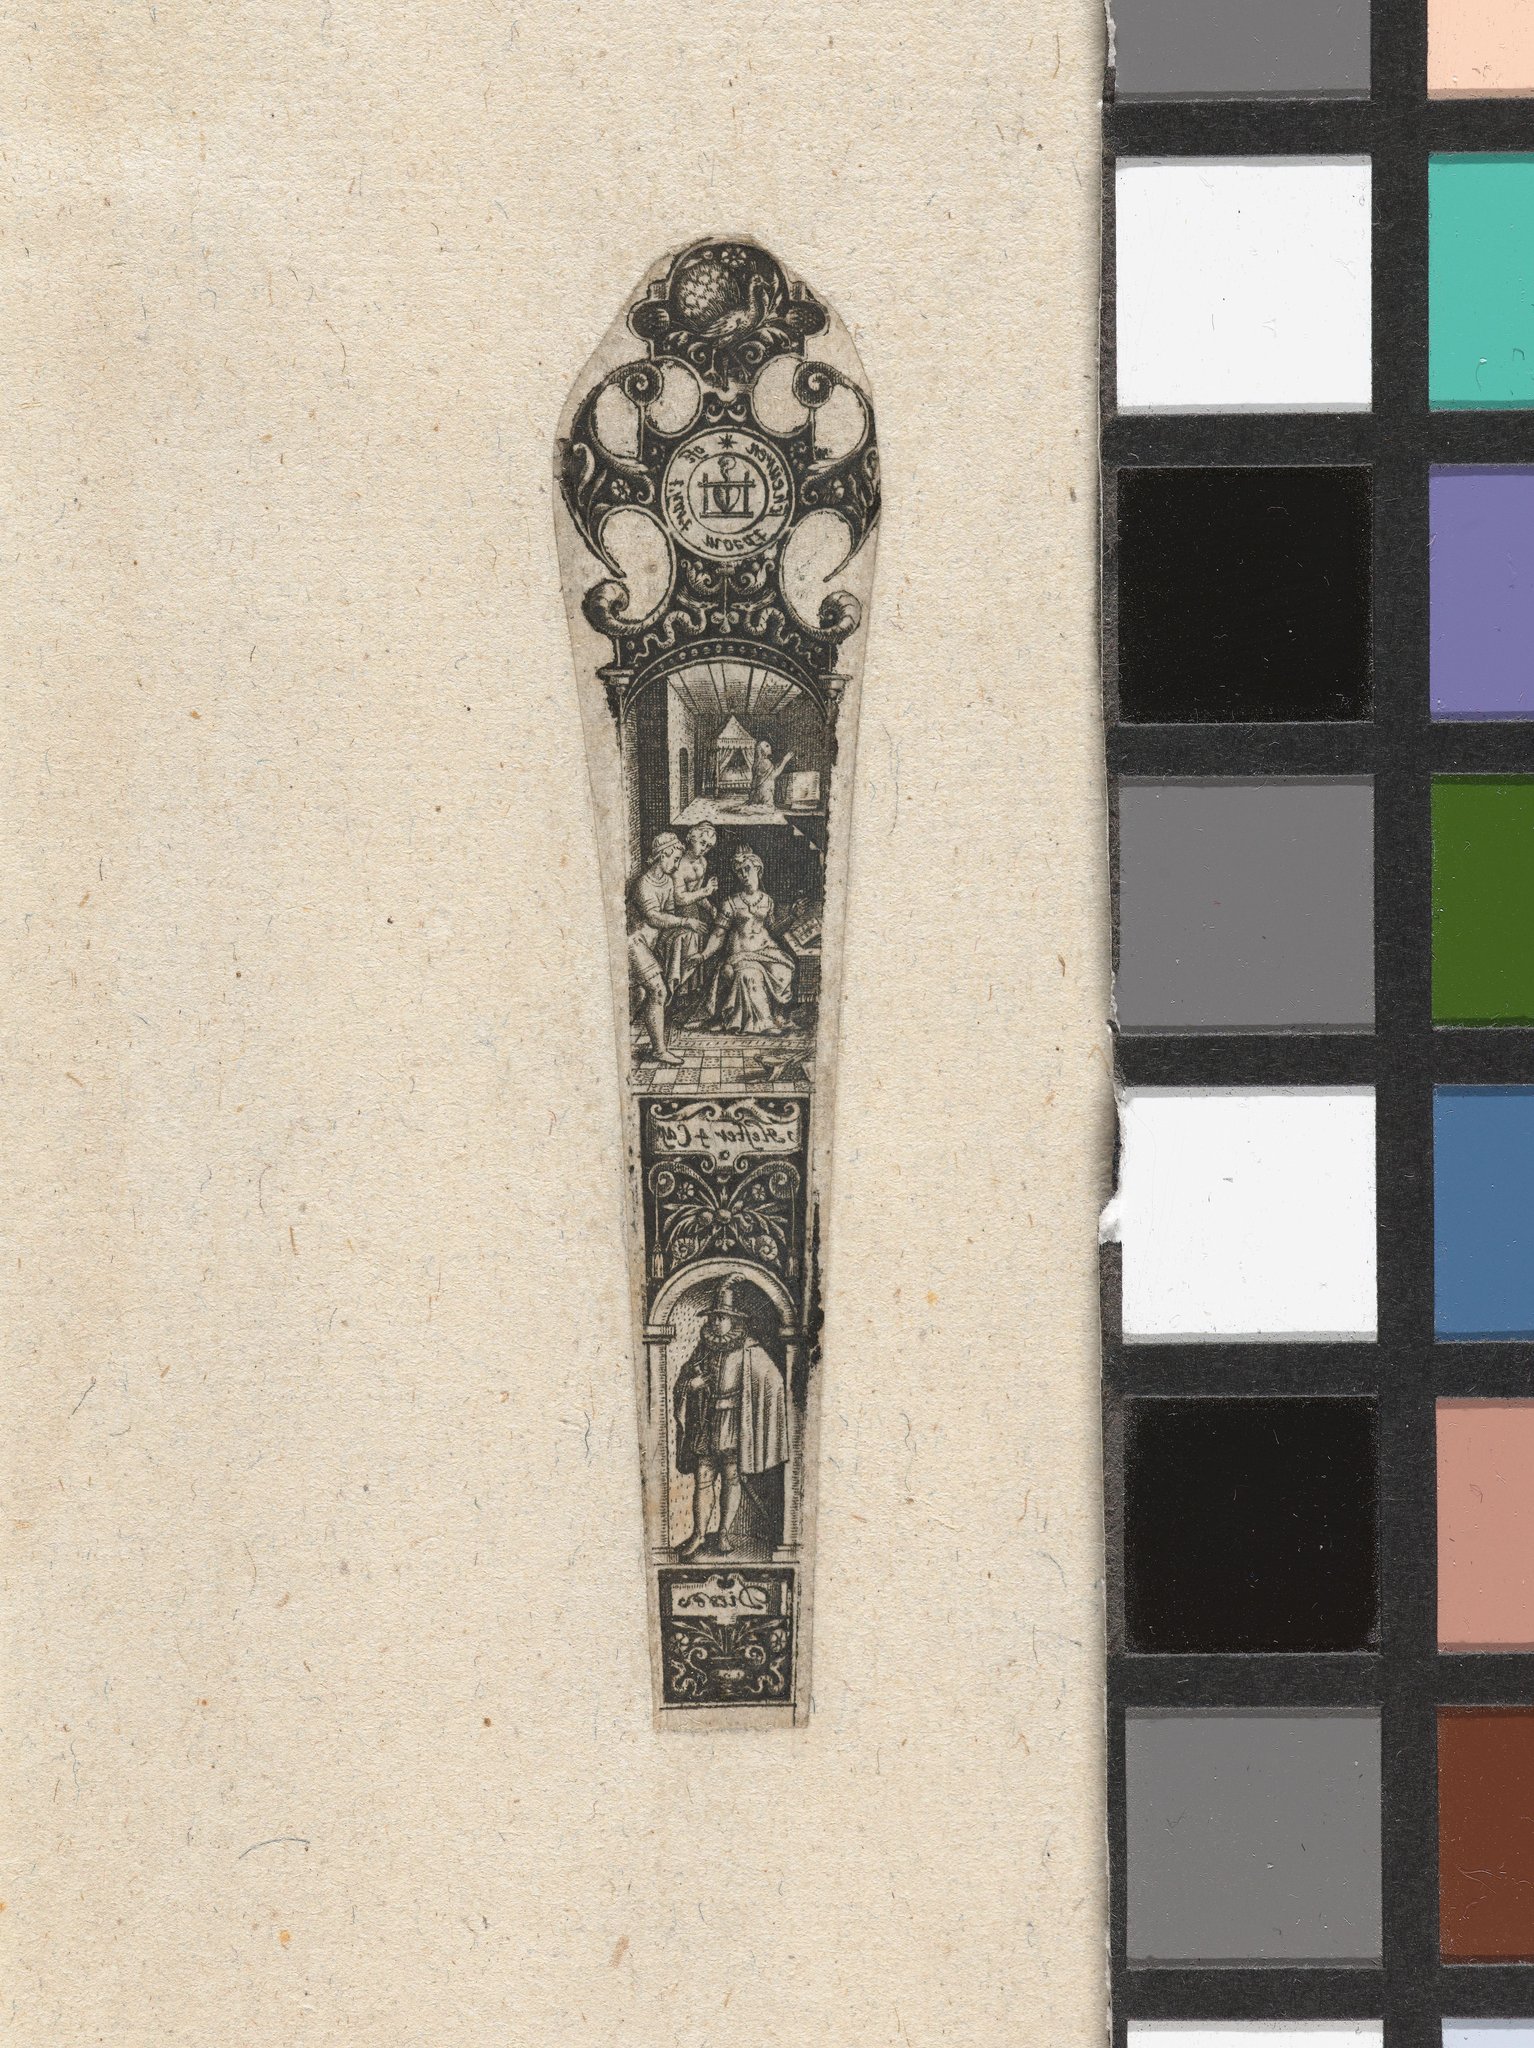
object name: ornament print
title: Mesheft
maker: Anonymous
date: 1500-1610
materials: paper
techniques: engraving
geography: netherlands